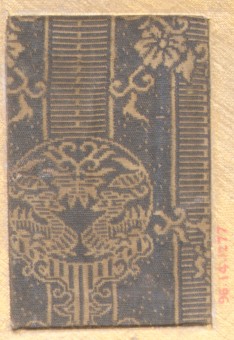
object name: piece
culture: japanese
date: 1701-1900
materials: silk